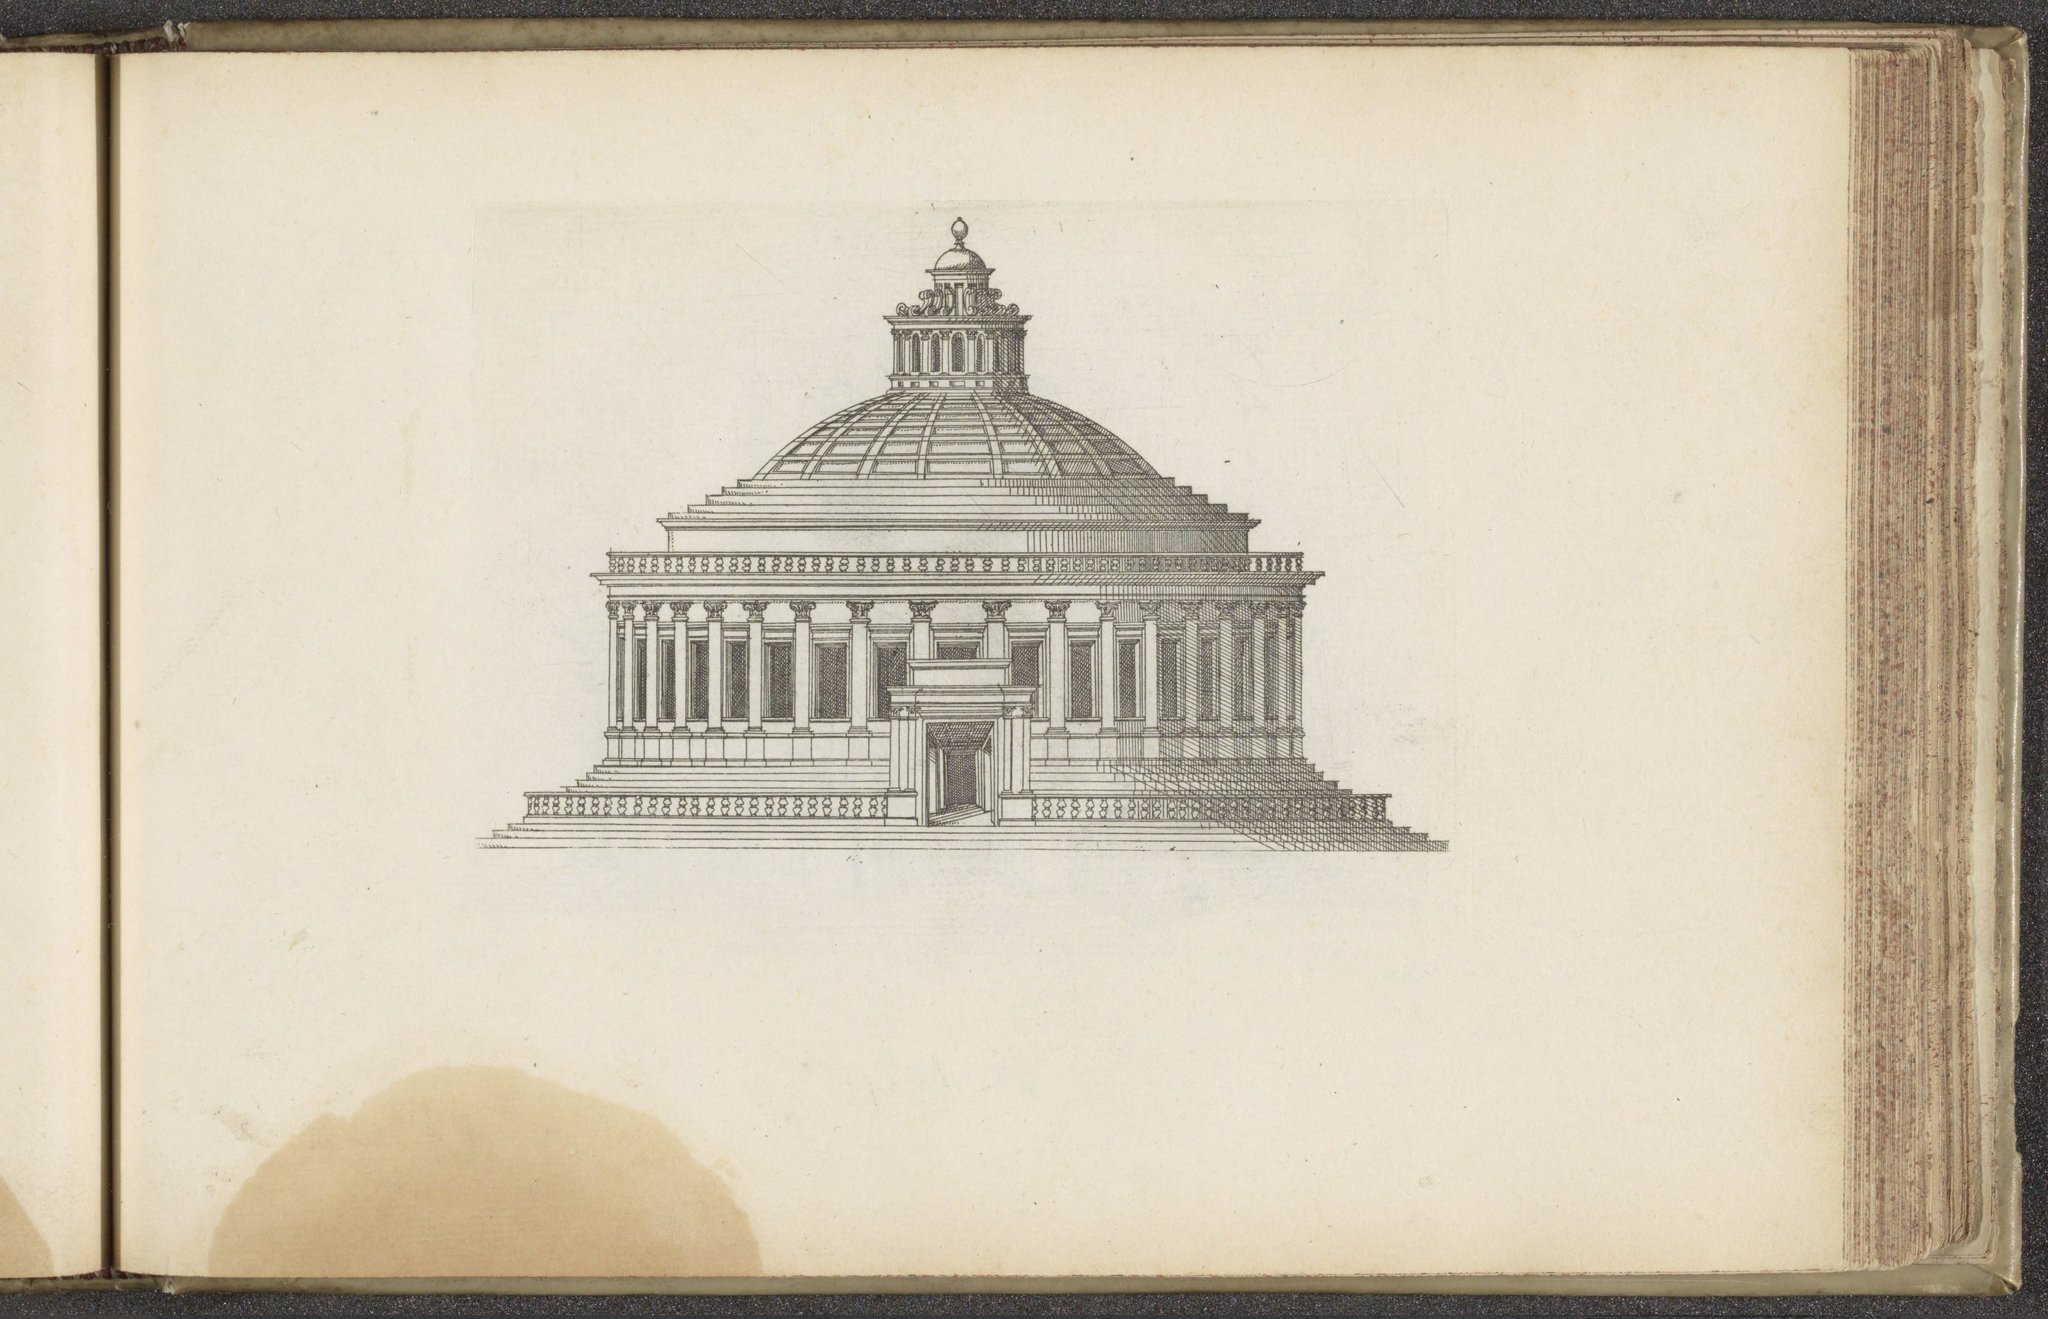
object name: print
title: Iacobus Androuetius Du Cerceau Lectoribus S Quoniam apud veteres alio structurae genere templa (...)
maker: jacques androuet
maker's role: draughtsman, print maker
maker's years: 1515-1584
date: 1550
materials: paper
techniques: etching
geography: orléans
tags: exterior ~ representation of a building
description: Ronde tempel. Deze prent maakt deel uit van een album.